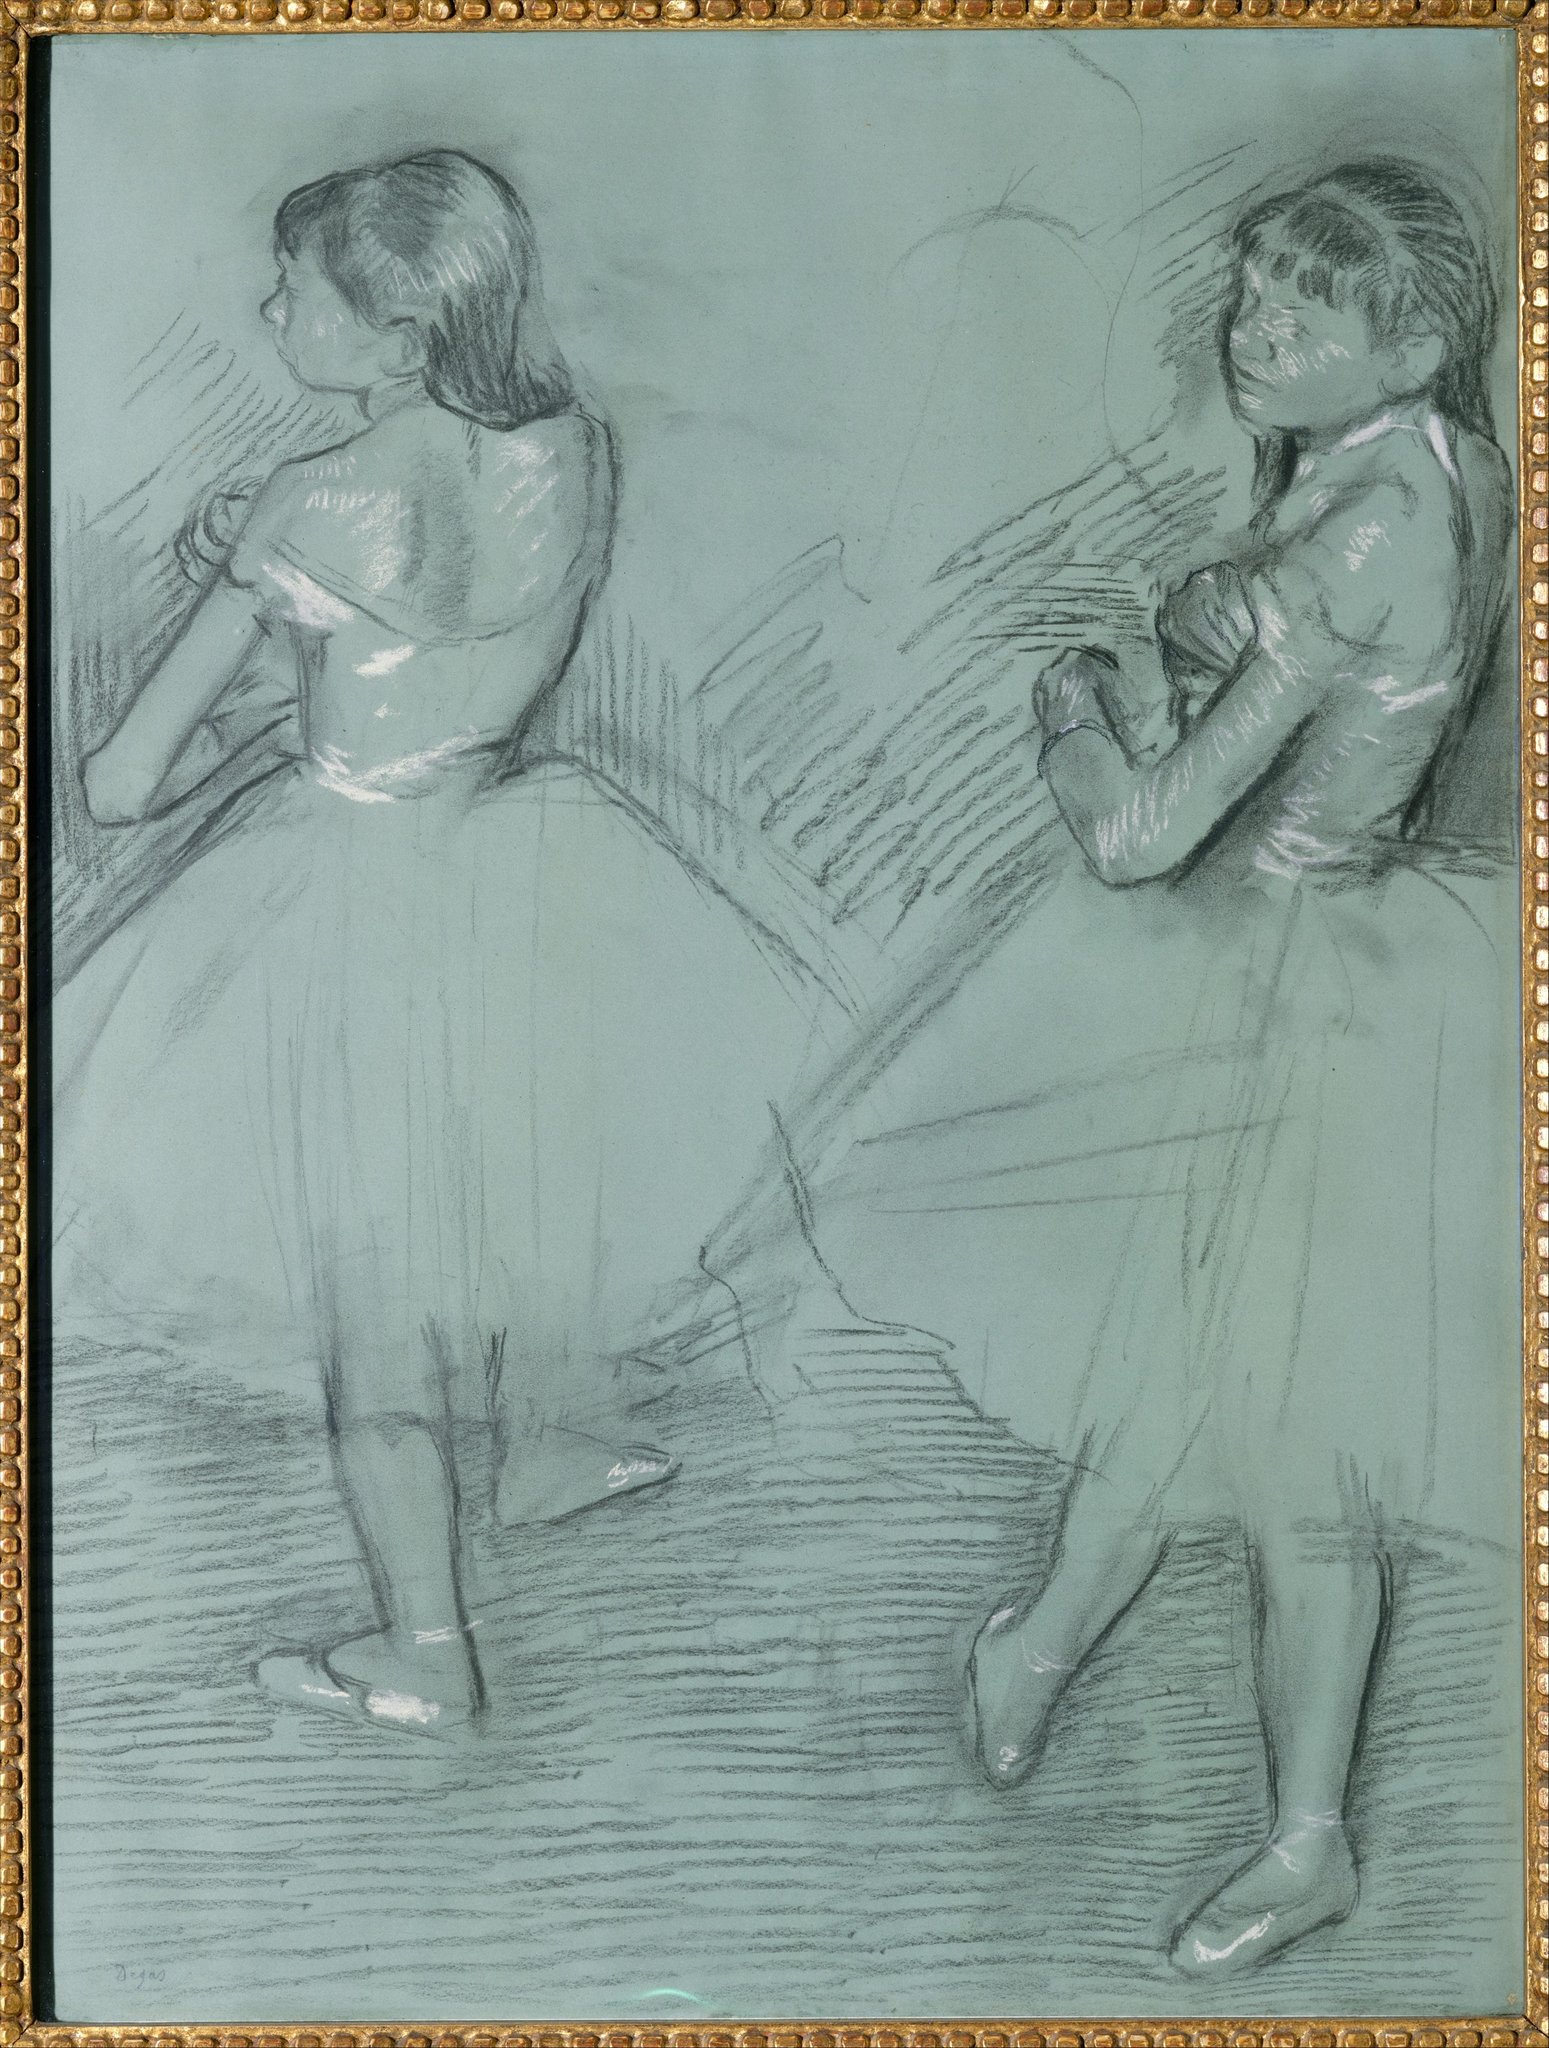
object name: drawing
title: Two Dancers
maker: edgar degas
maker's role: artist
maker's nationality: french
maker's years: 1834-1917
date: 1879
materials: chalk, charcoal, paper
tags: girls,dancers,ballet